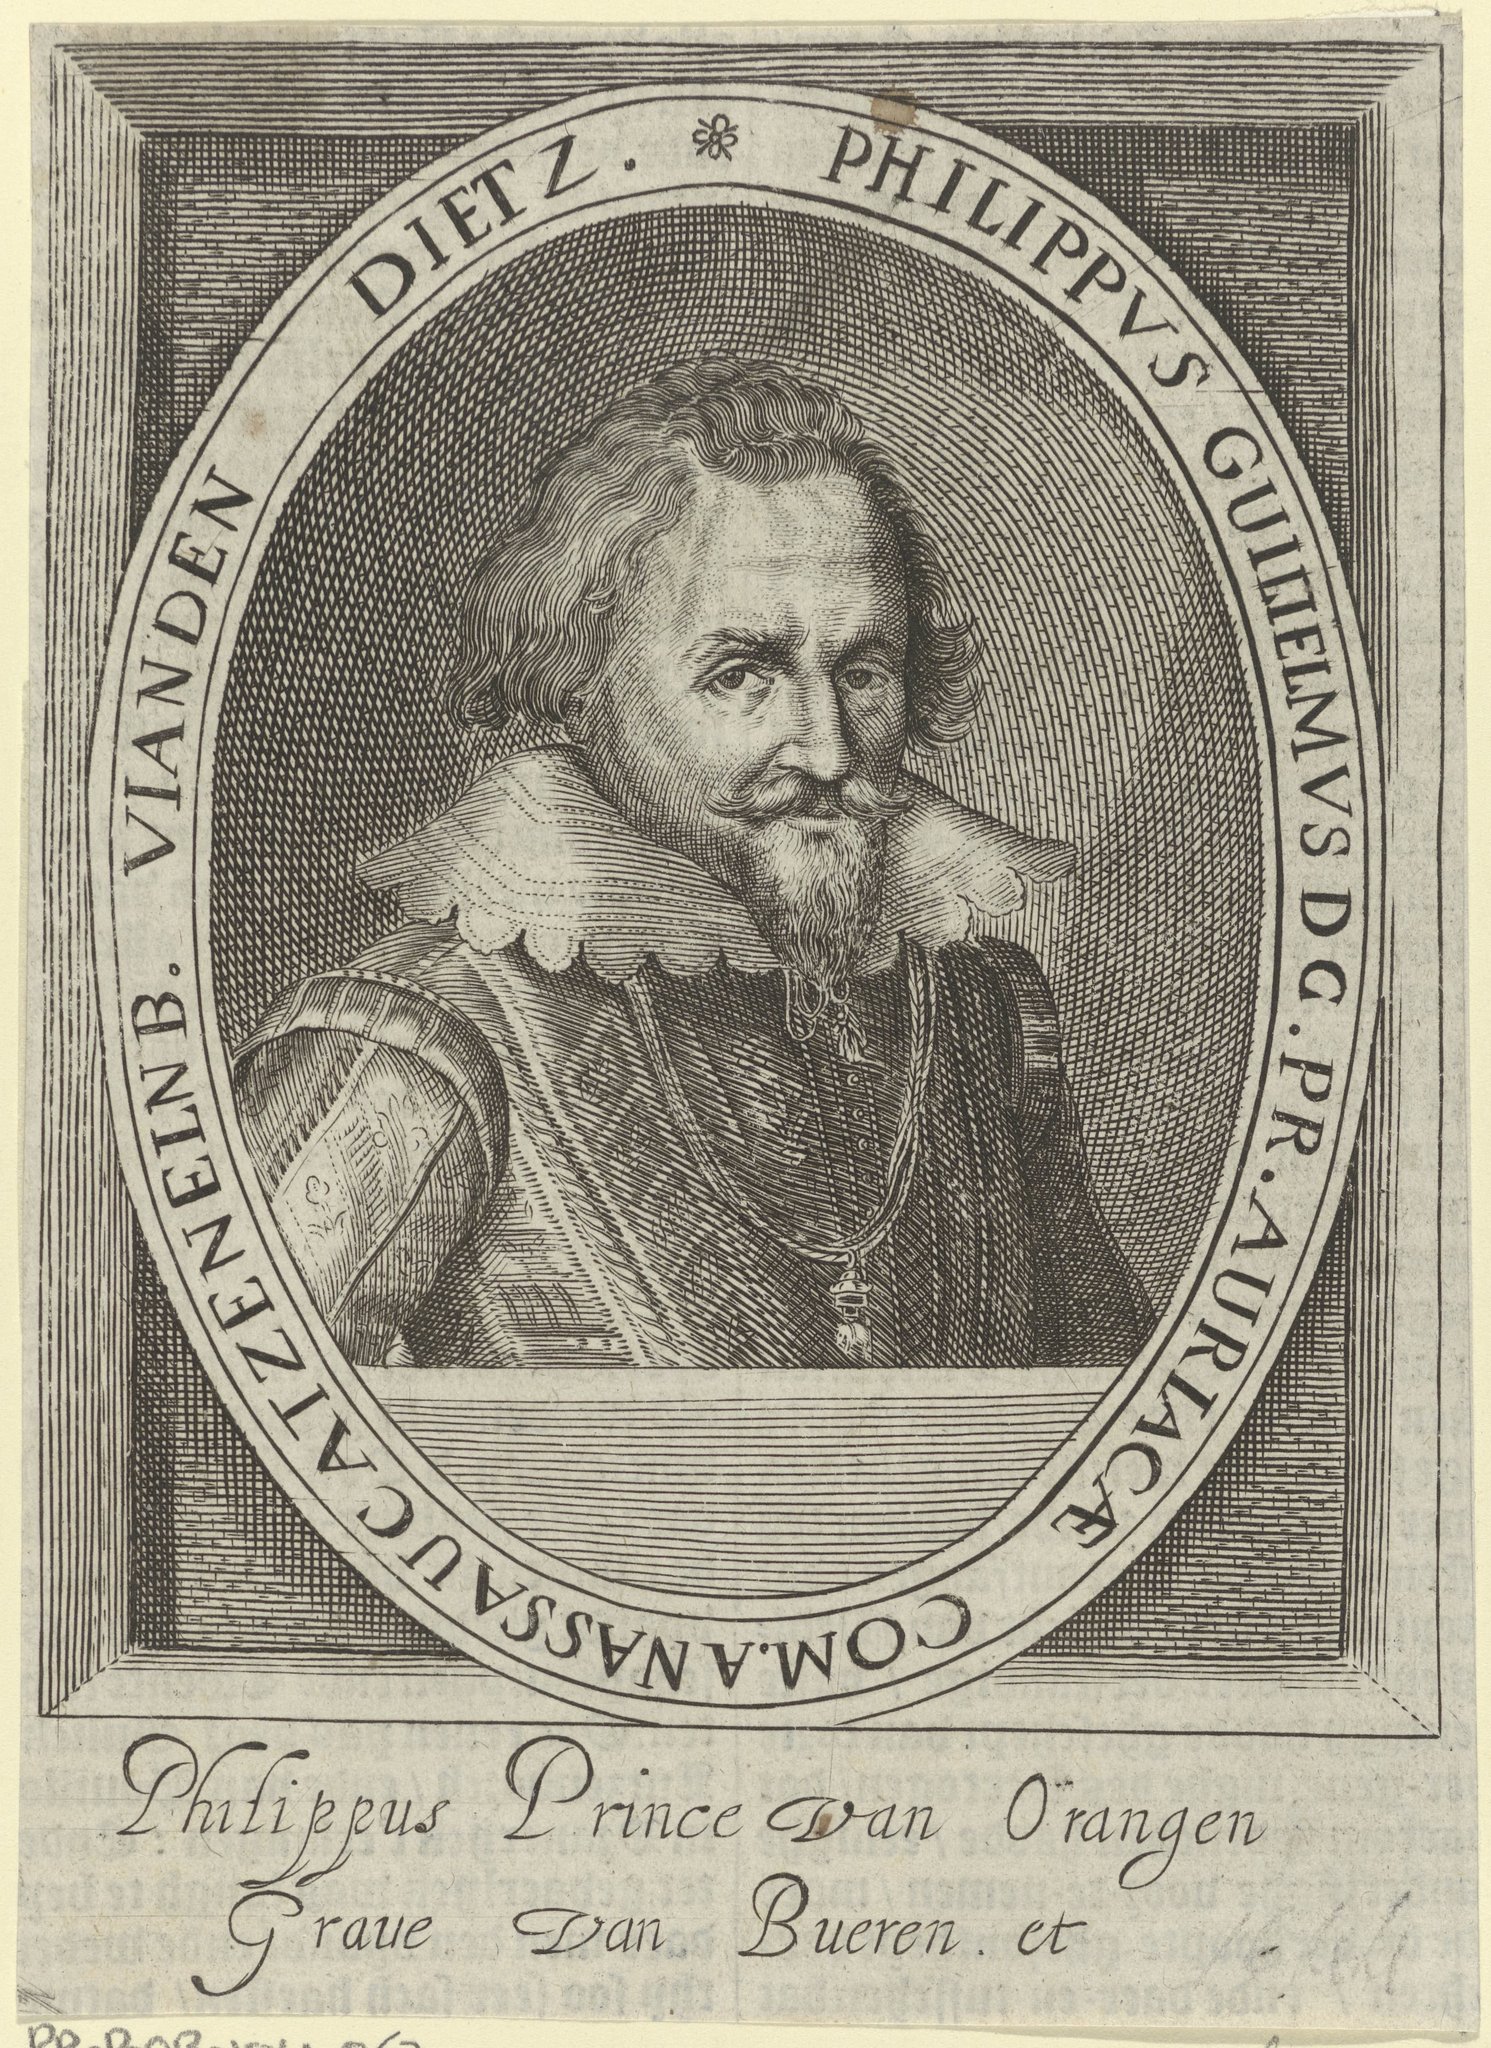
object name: book illustration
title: Portret van Filips Willem, prins van Oranje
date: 1663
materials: paper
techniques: engraving, etching, letterpress printing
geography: amsterdam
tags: buren, bruges, filips willem (prins van oranje), knighthood order of the golden fleece - insignia of a knighthood order, e.g.: badge, chain (with name of order)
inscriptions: collector's mark: Lugt 963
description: De hier vermelde titel verwijst naar de hoogst verkregen titel van de geportretteerde, niet per se naar de titel die de geportretteerde op deze voorstelling draagt. Prent uit: Meteren, Emanuel van. Historien der Nederlanden, en haar naburen oorlogen tot het iaar 1612. Amsterdam: Jan Jacobsz Schipper, 1663.